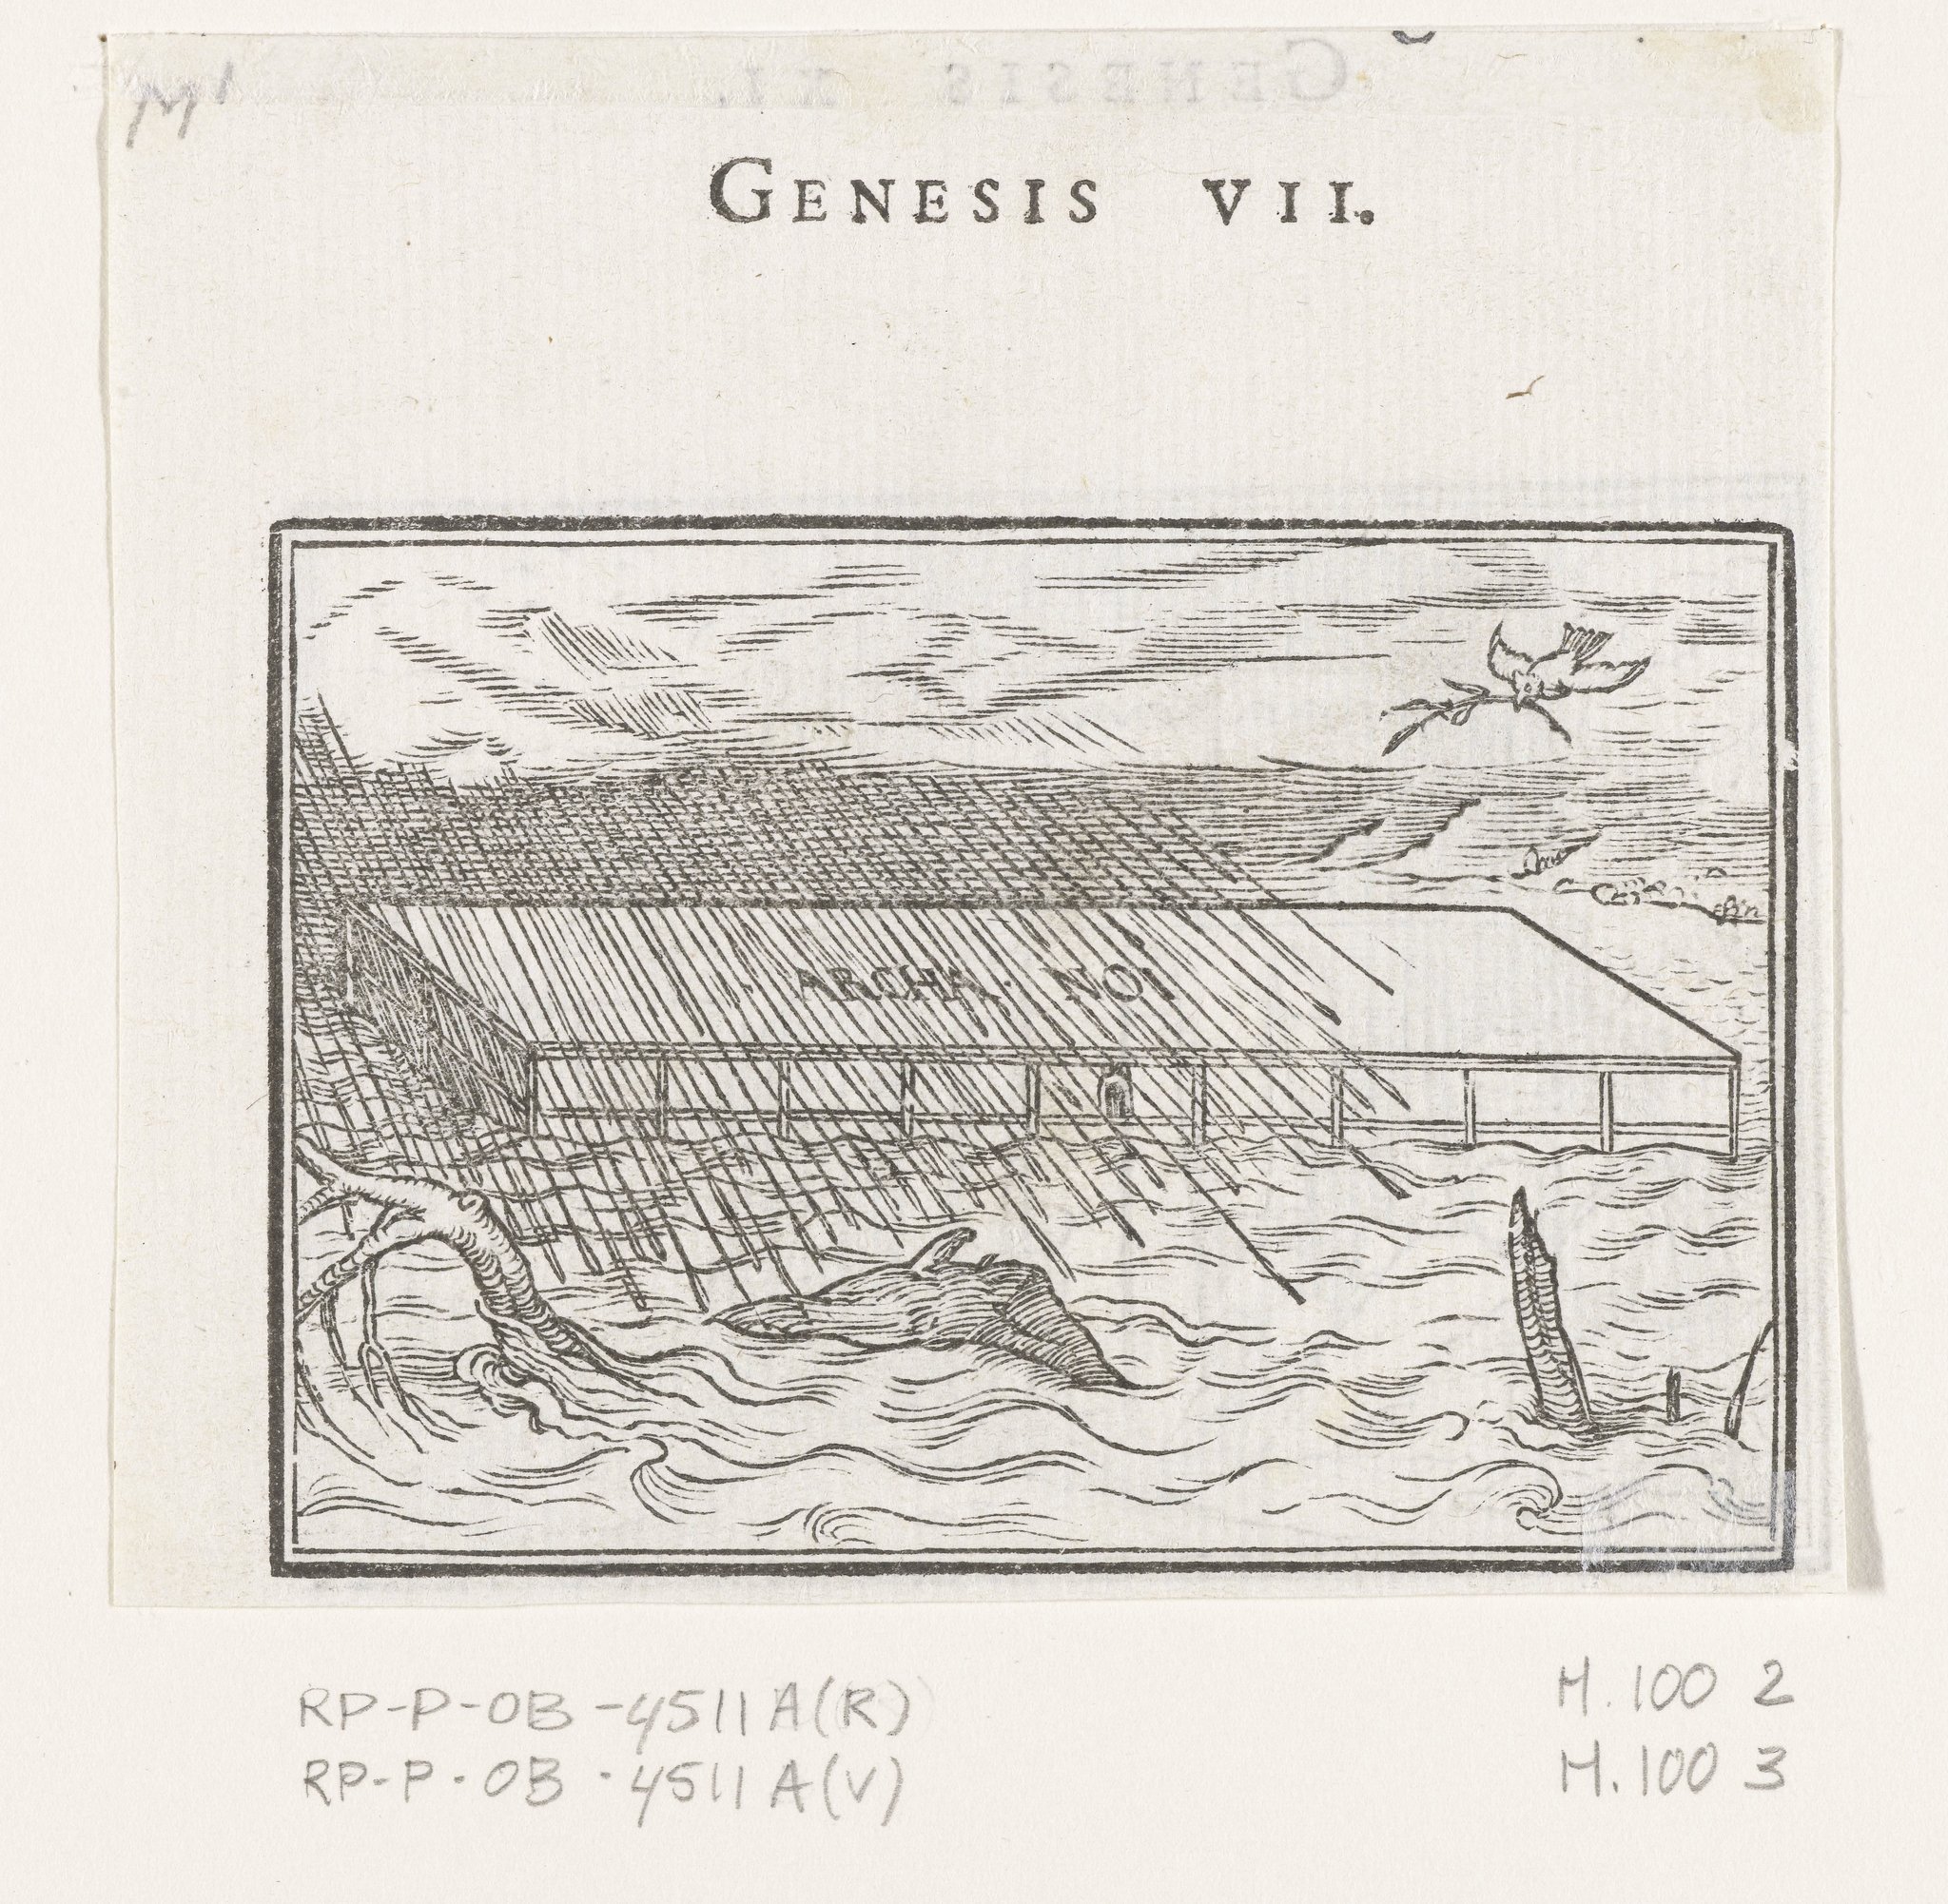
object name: book illustration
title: Ark van Noach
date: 1538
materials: paper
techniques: woodcut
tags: the dove returns with an olive-branch ~ story of noah, the ark floating on the waters (destruction of mankind not visible)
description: Houtblok voor het eerst gebruikt in: Biblia Utriusque Testamenti iuxta Vulgatam Translationem, Lyon, M. en G. Trechsel (voor Hugo à Porta) 1538. Later in verschillende uitgaven opnieuw gebruikt.